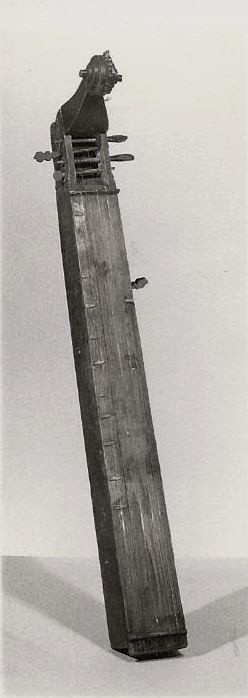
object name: langeleik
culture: norwegian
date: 1799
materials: metal, wood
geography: norway